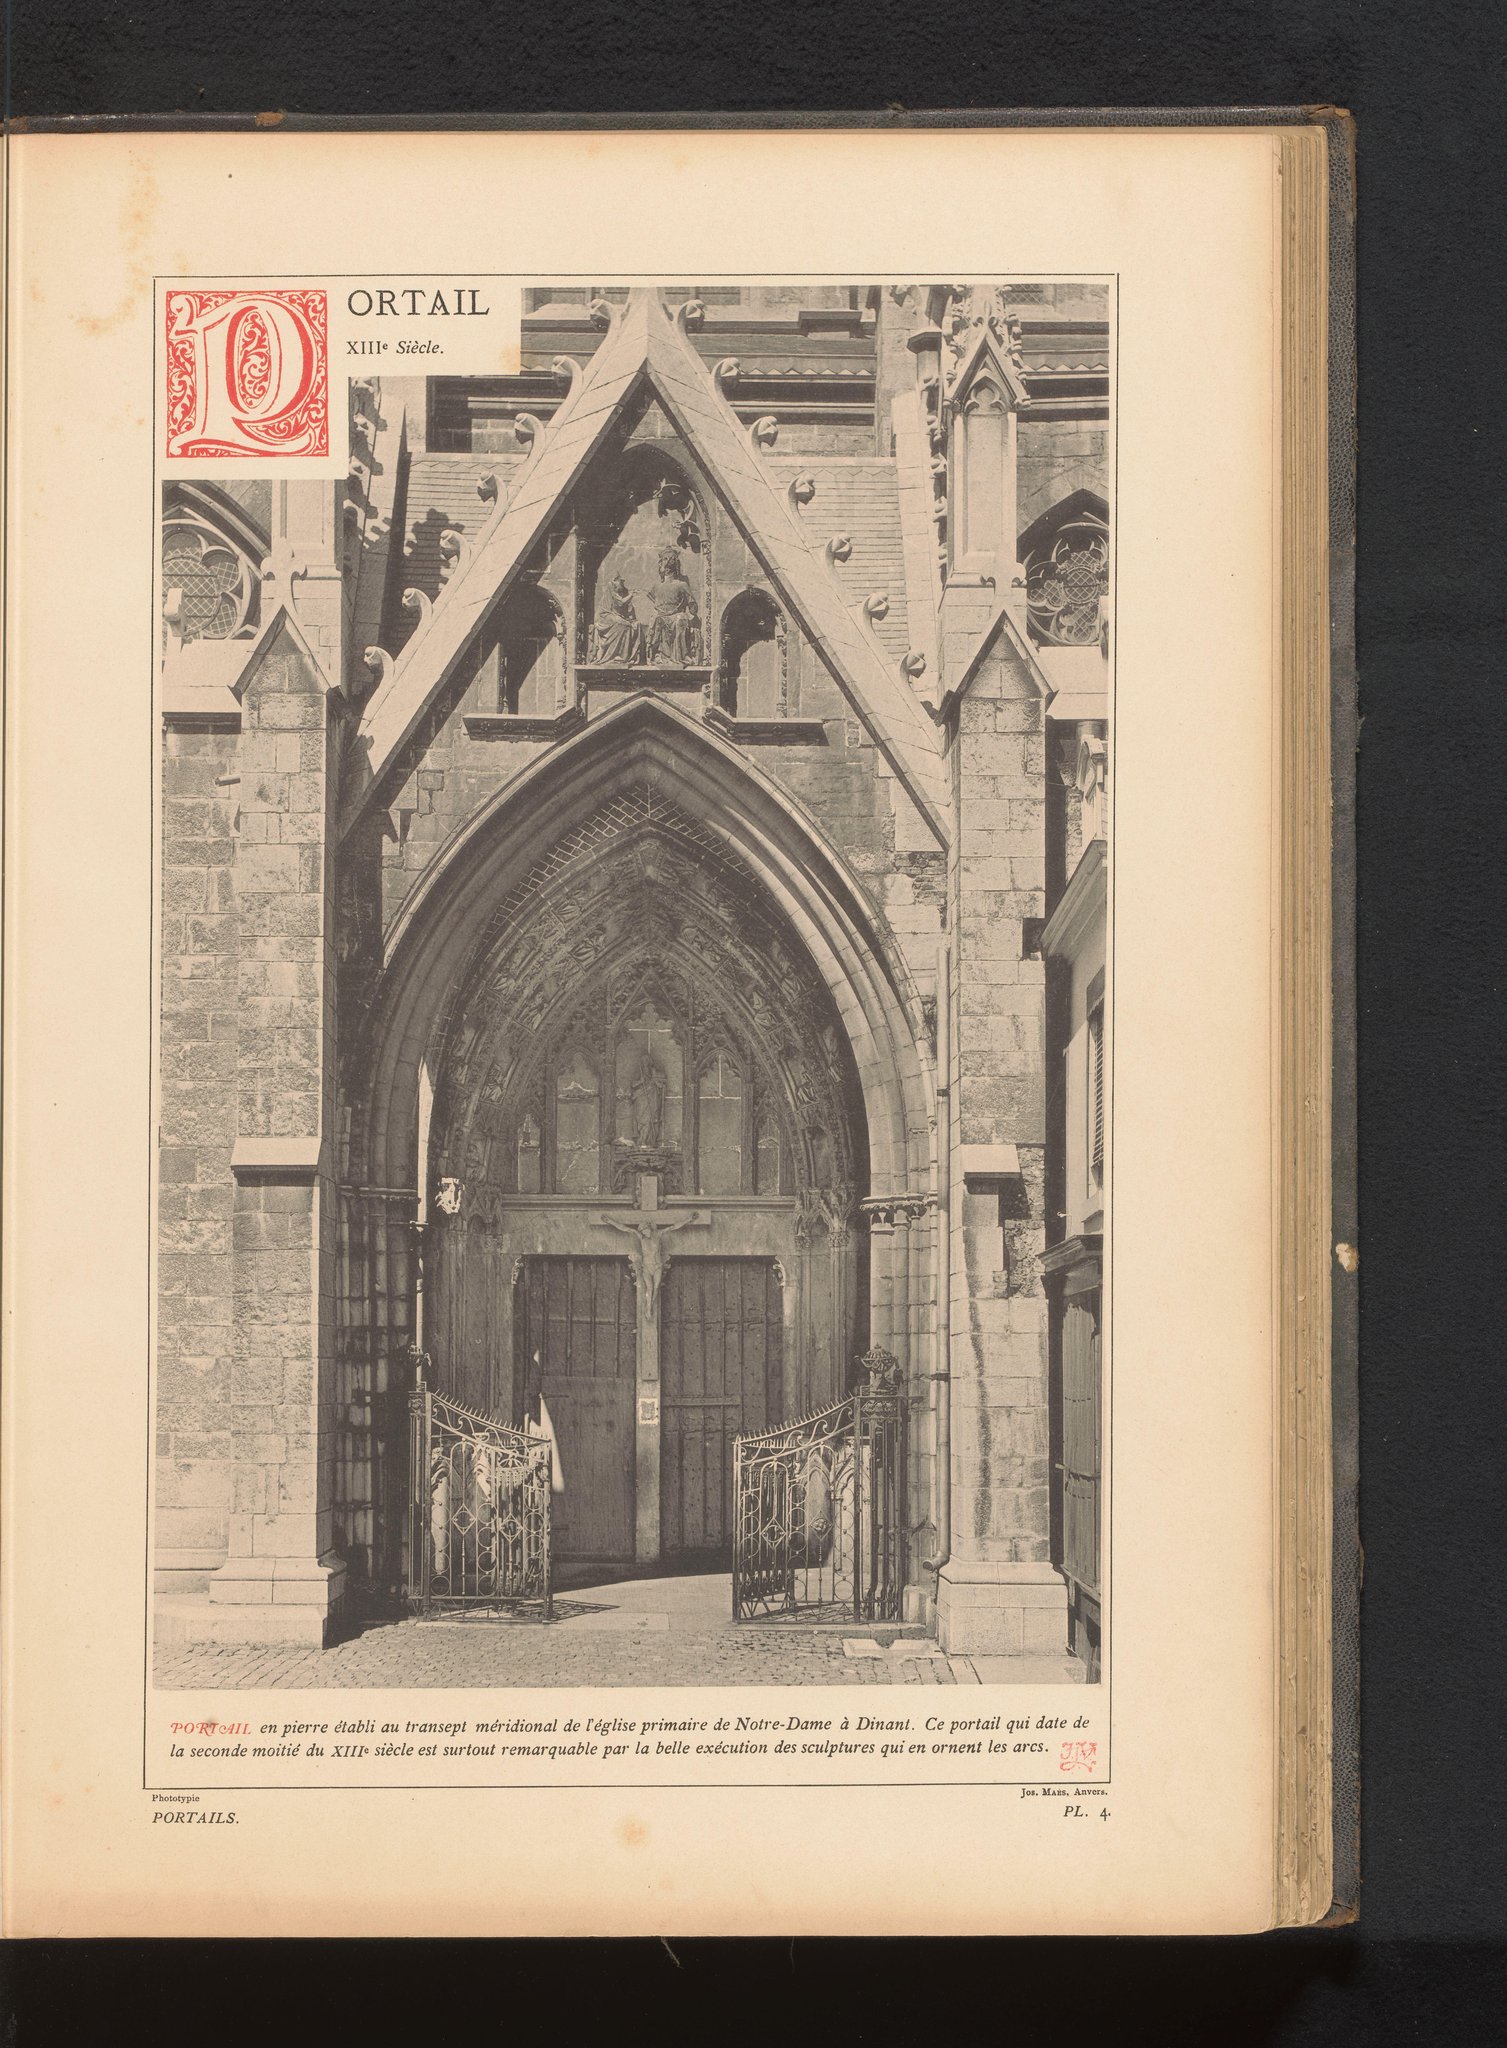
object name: photomechanical print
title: Portail, XIIIe Siècle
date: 1881-1889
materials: paper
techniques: photograph, photolithography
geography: dinant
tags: parts of church exterior and annexes: portal, parts of church interior: transept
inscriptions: monogram: ‘JJvY’, inscription: ‘PORTAIL en pierre (...)’, inscription: ‘PORTAILS. PL. 4.’